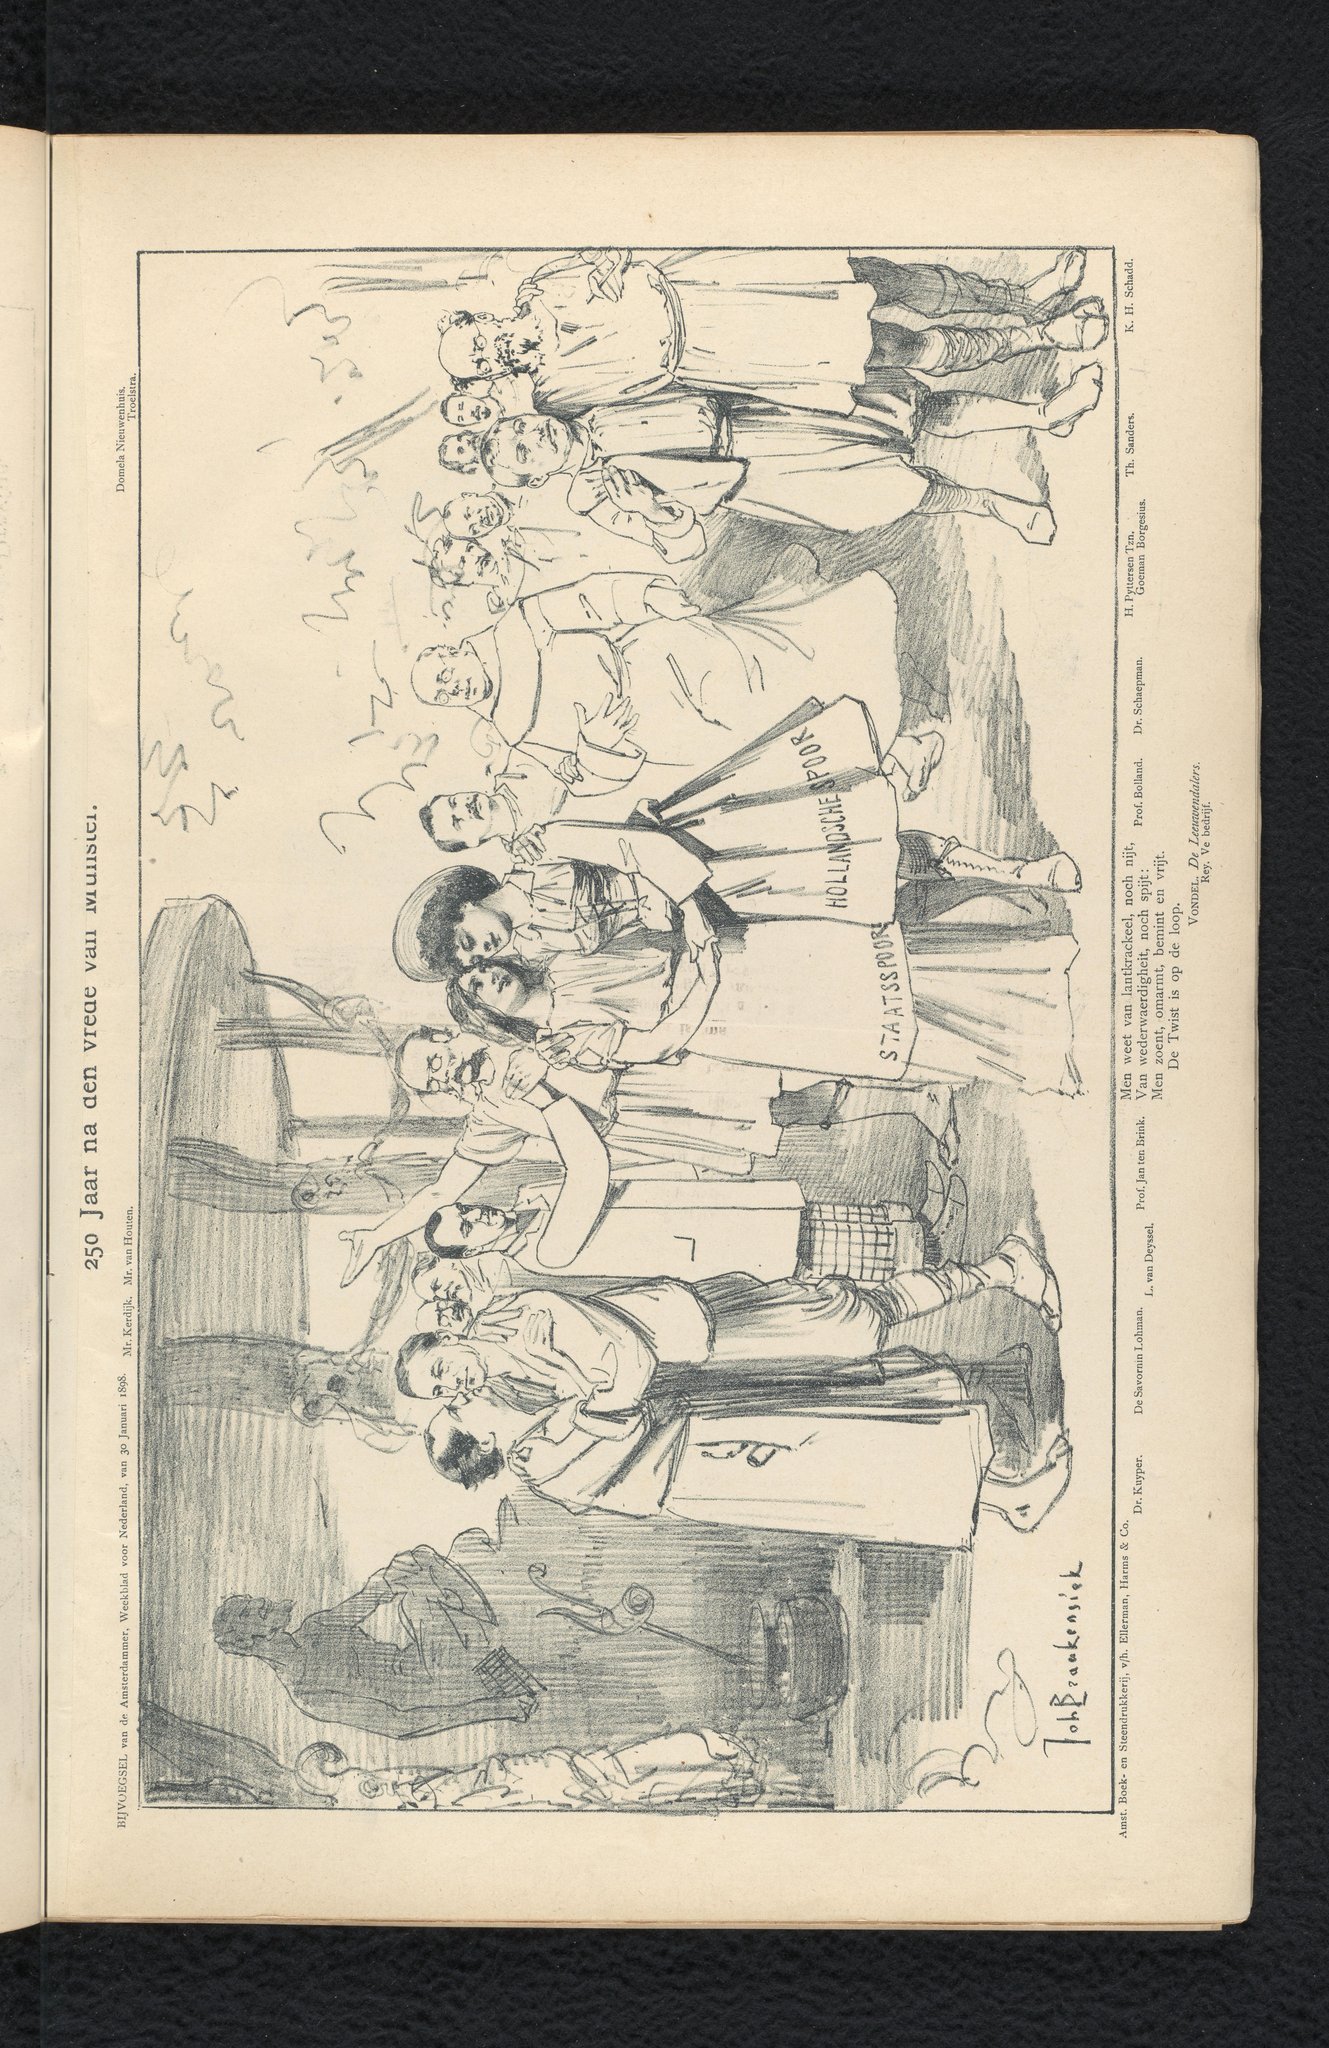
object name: cartoon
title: 250 Jaar na den vrede van Munster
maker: johan braakensiek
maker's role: draughtsman, print maker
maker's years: 1858-1940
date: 1898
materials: paper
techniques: lithograph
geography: netherlands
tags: friendliness, gentleness, affability; 'affabilità, piacevolezza, amabilità', 'animo piacevole, trattabile & amorevole', 'benignità' (ripa), embracing each other, kissing, friendship; 'amicitia' (ripa), peace, political caricatures and satires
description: De vrede wordt gesloten tussen de Staatsspoorwegen en de Hollandsche IJzeren Spoorweg-Maatschappij. Ook alle binnenlandse politieke tegenstanders omhelzen elkaar en sluiten vrede.